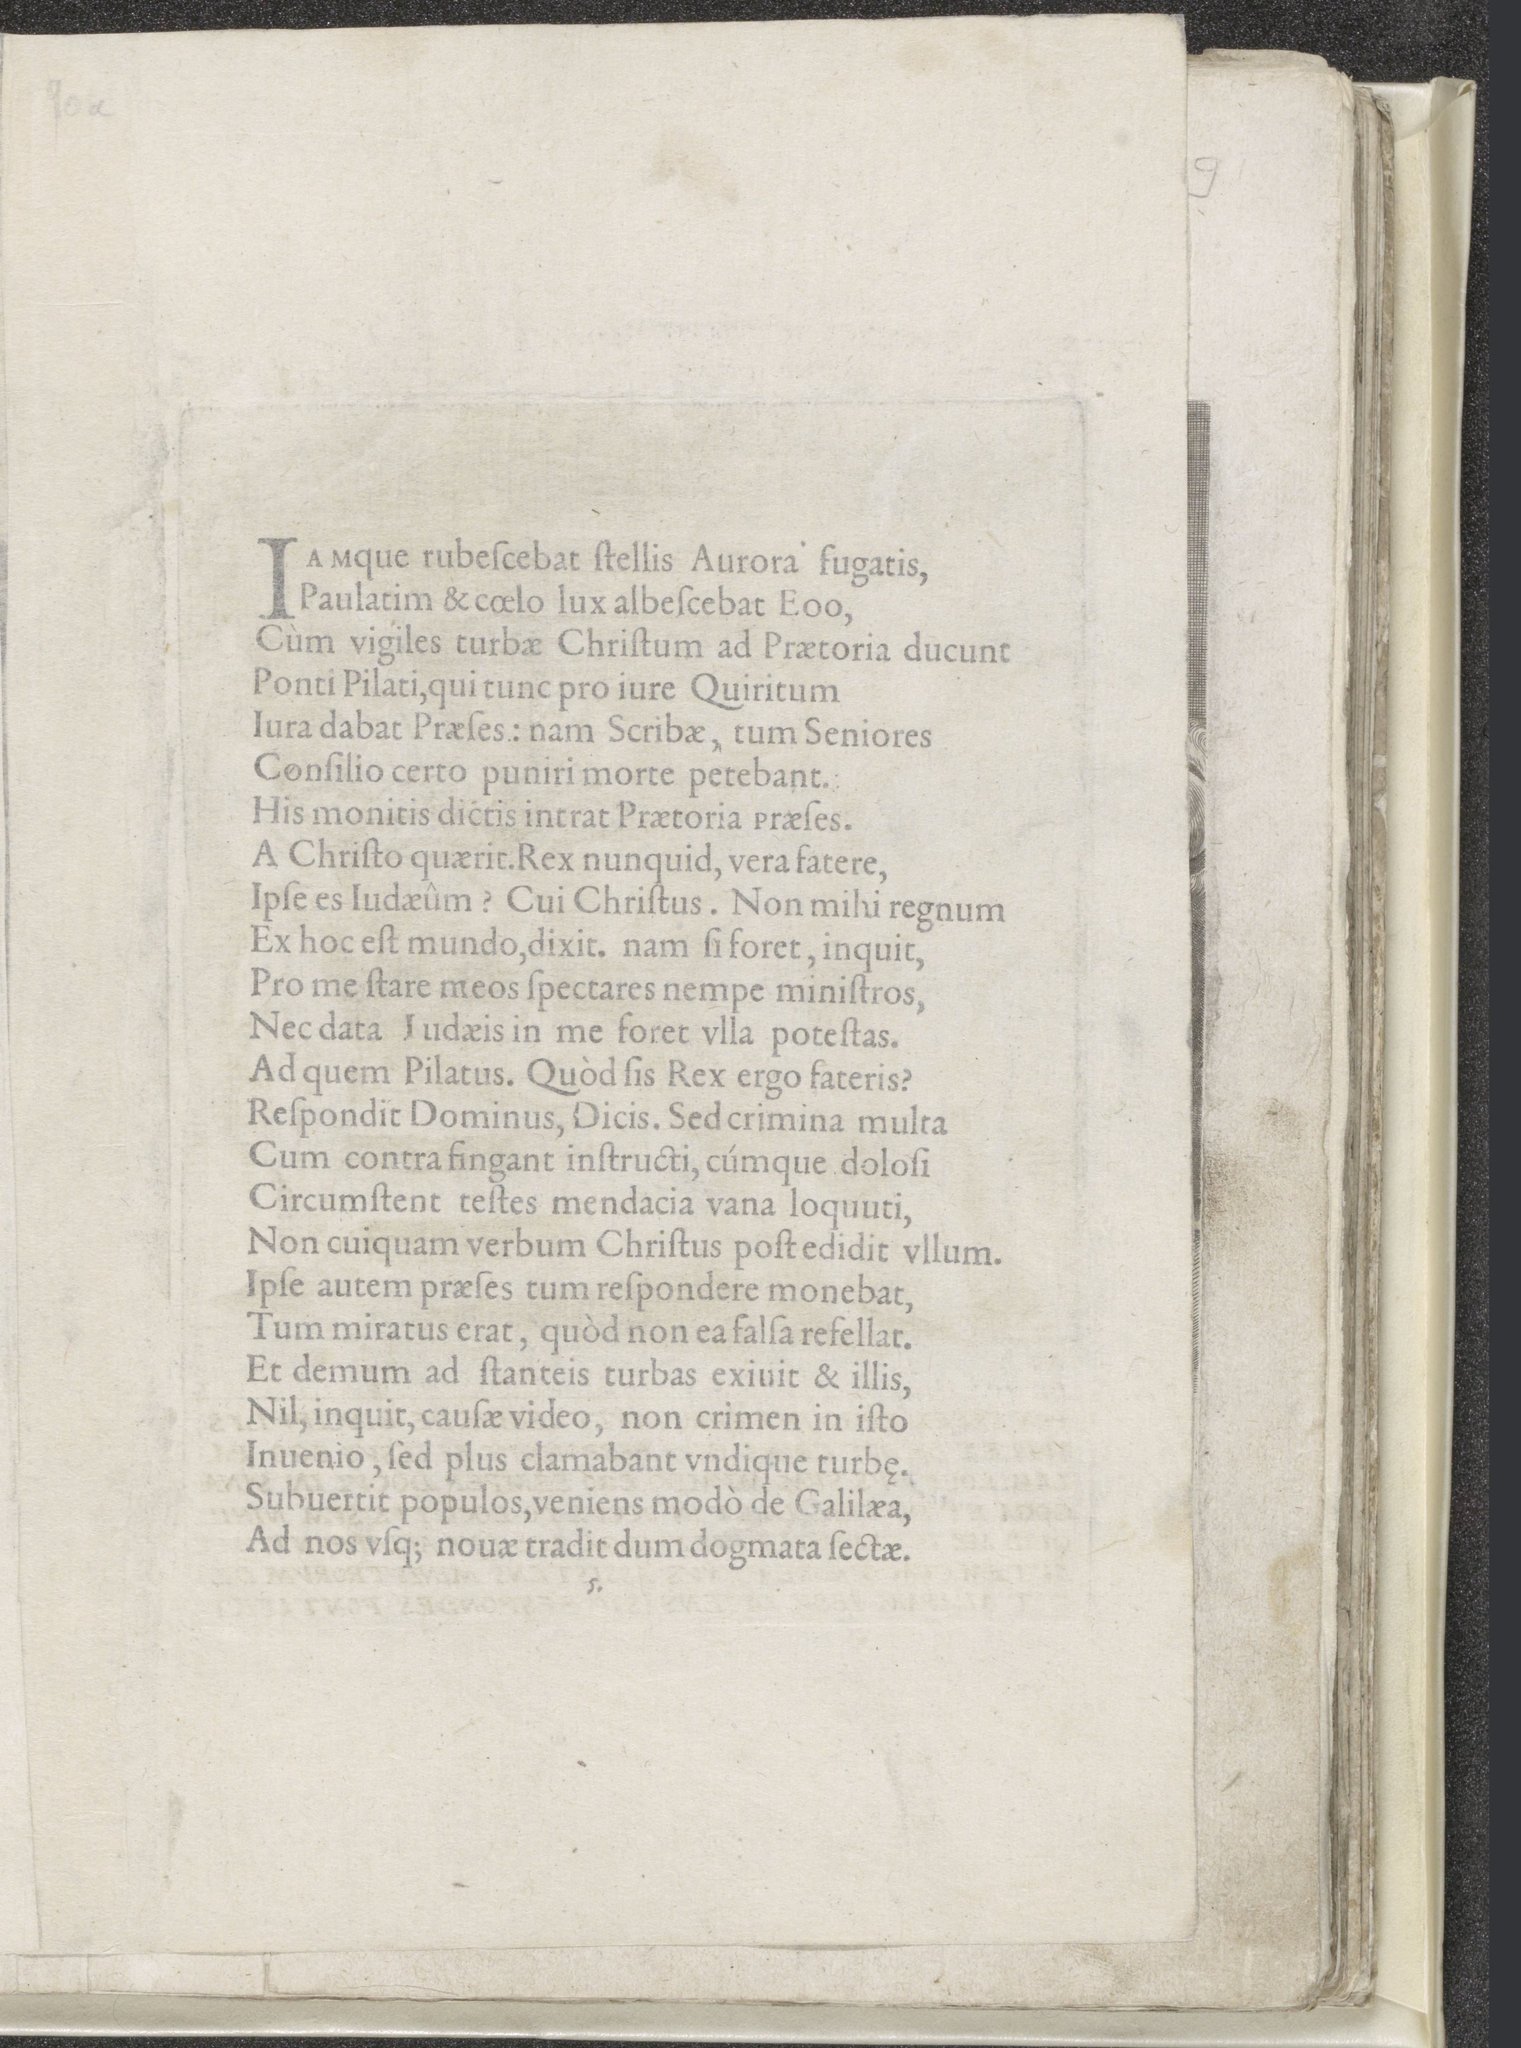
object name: album leaf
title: Tekst over Christus voor Pilatus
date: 1572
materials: paper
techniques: letterpress printing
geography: antwerp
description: Tijdens de restauratie in 1988 bleek dat op de achterzijde van de prenten van de Passie-serie van Wierix Latijnse teksten in boekdruk staan. Deze vormen, wanneer op de juiste wijze in boekvorm gebonden (wat nu in het Heemskerck-album niet het geval is), een toelichting op de passievoorstellingen. Om de teksten zichtbaar te laten zijn de prenten bij de restauratie niet meer met de achterzijde op elkaar geplakt.